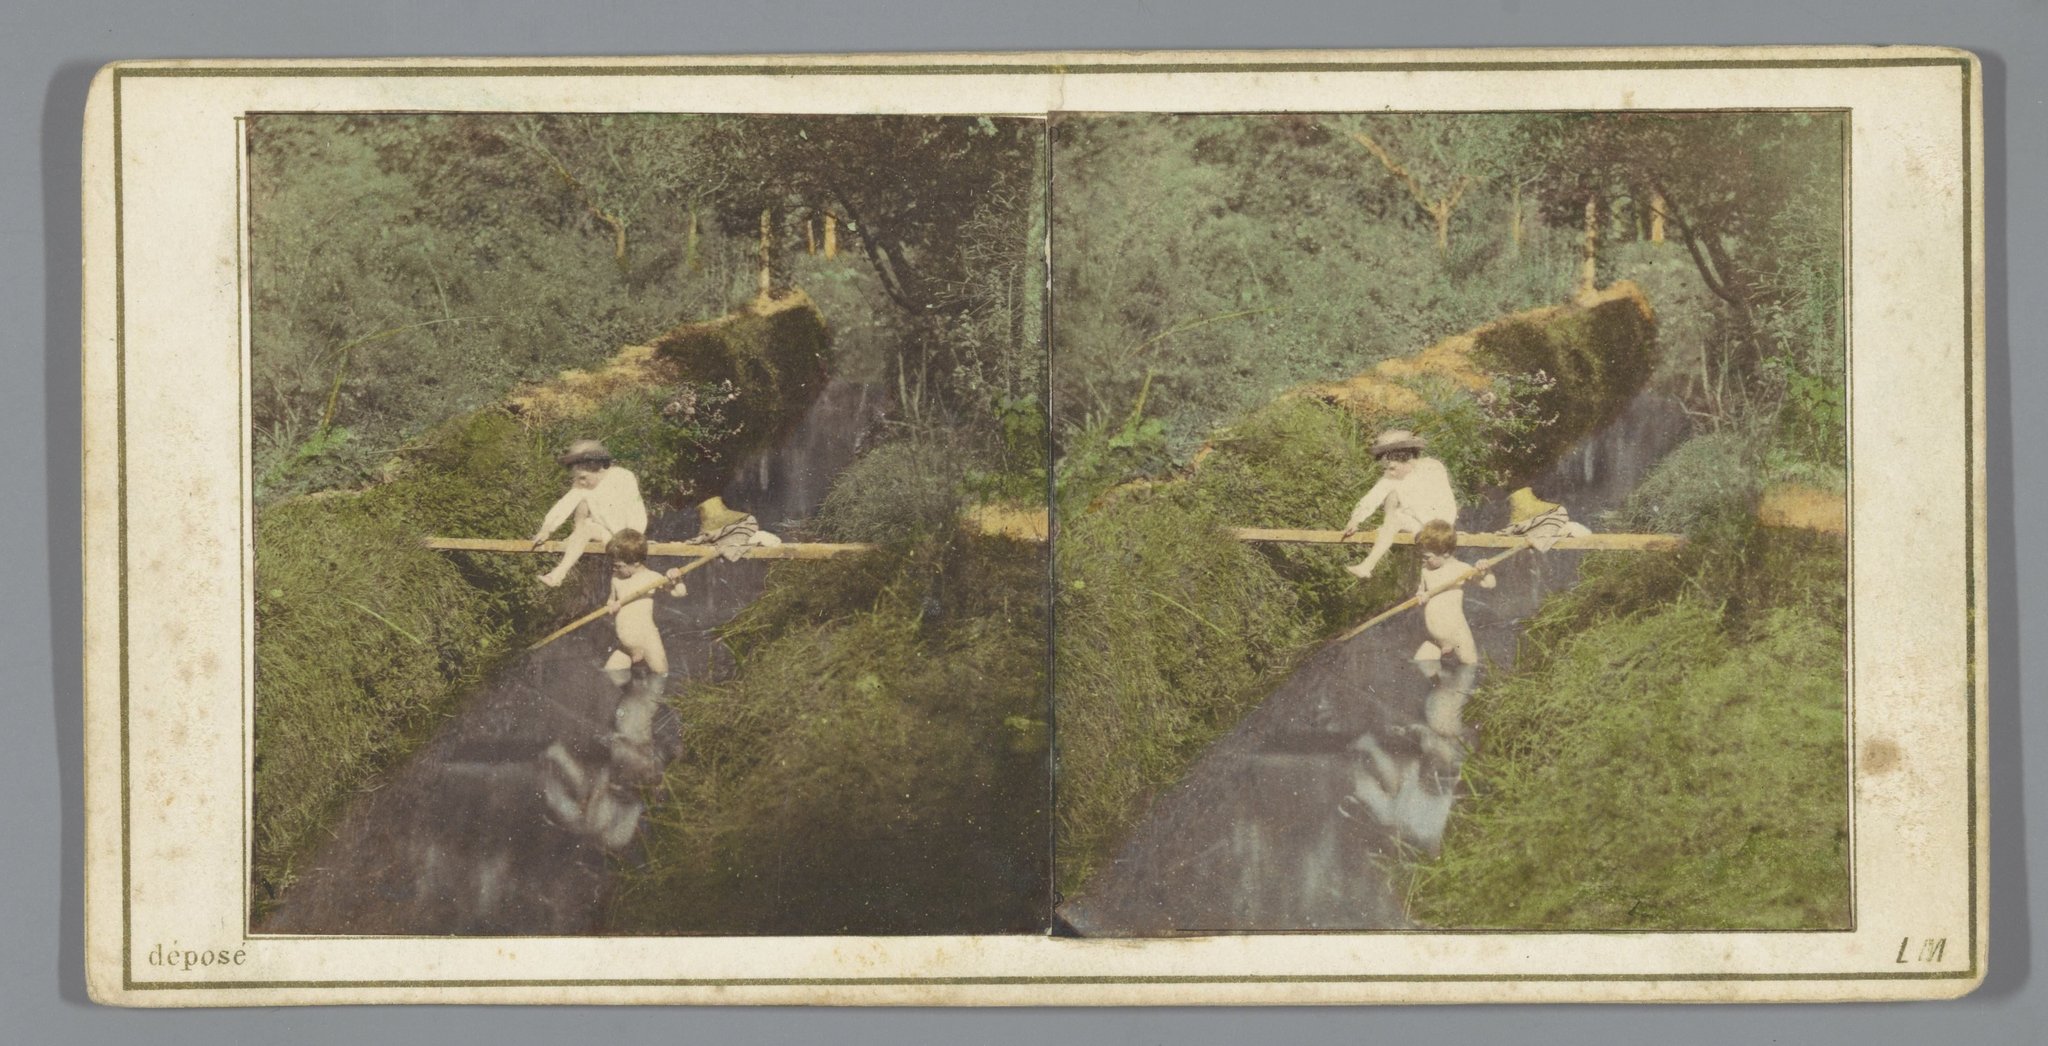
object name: stereograph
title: Spelende kinderen in een bosbeek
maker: lm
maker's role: fotograaf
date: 1852-1863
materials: cardboard, paper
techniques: albumen print, hand coloring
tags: forest, wood, brook, playing in the woods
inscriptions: inscription: ‘W: K: W: M:’, inscription: ‘175’, inscription: ‘déposé’